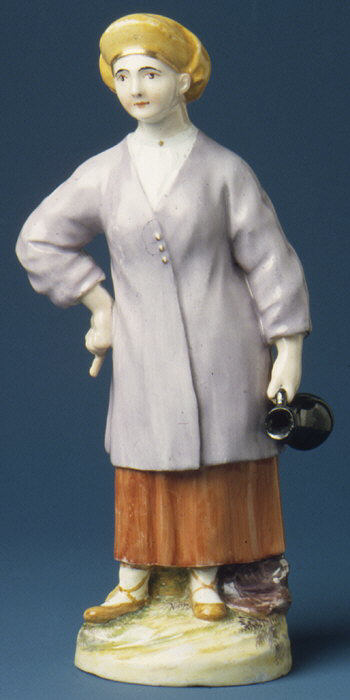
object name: figure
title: Peasant Woman from Ingria (Ingermanland)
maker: imperial porcelain manufactory, st. petersburg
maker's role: manufactory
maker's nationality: russian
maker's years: 1744-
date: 1780-1800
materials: hard paste porcelain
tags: women